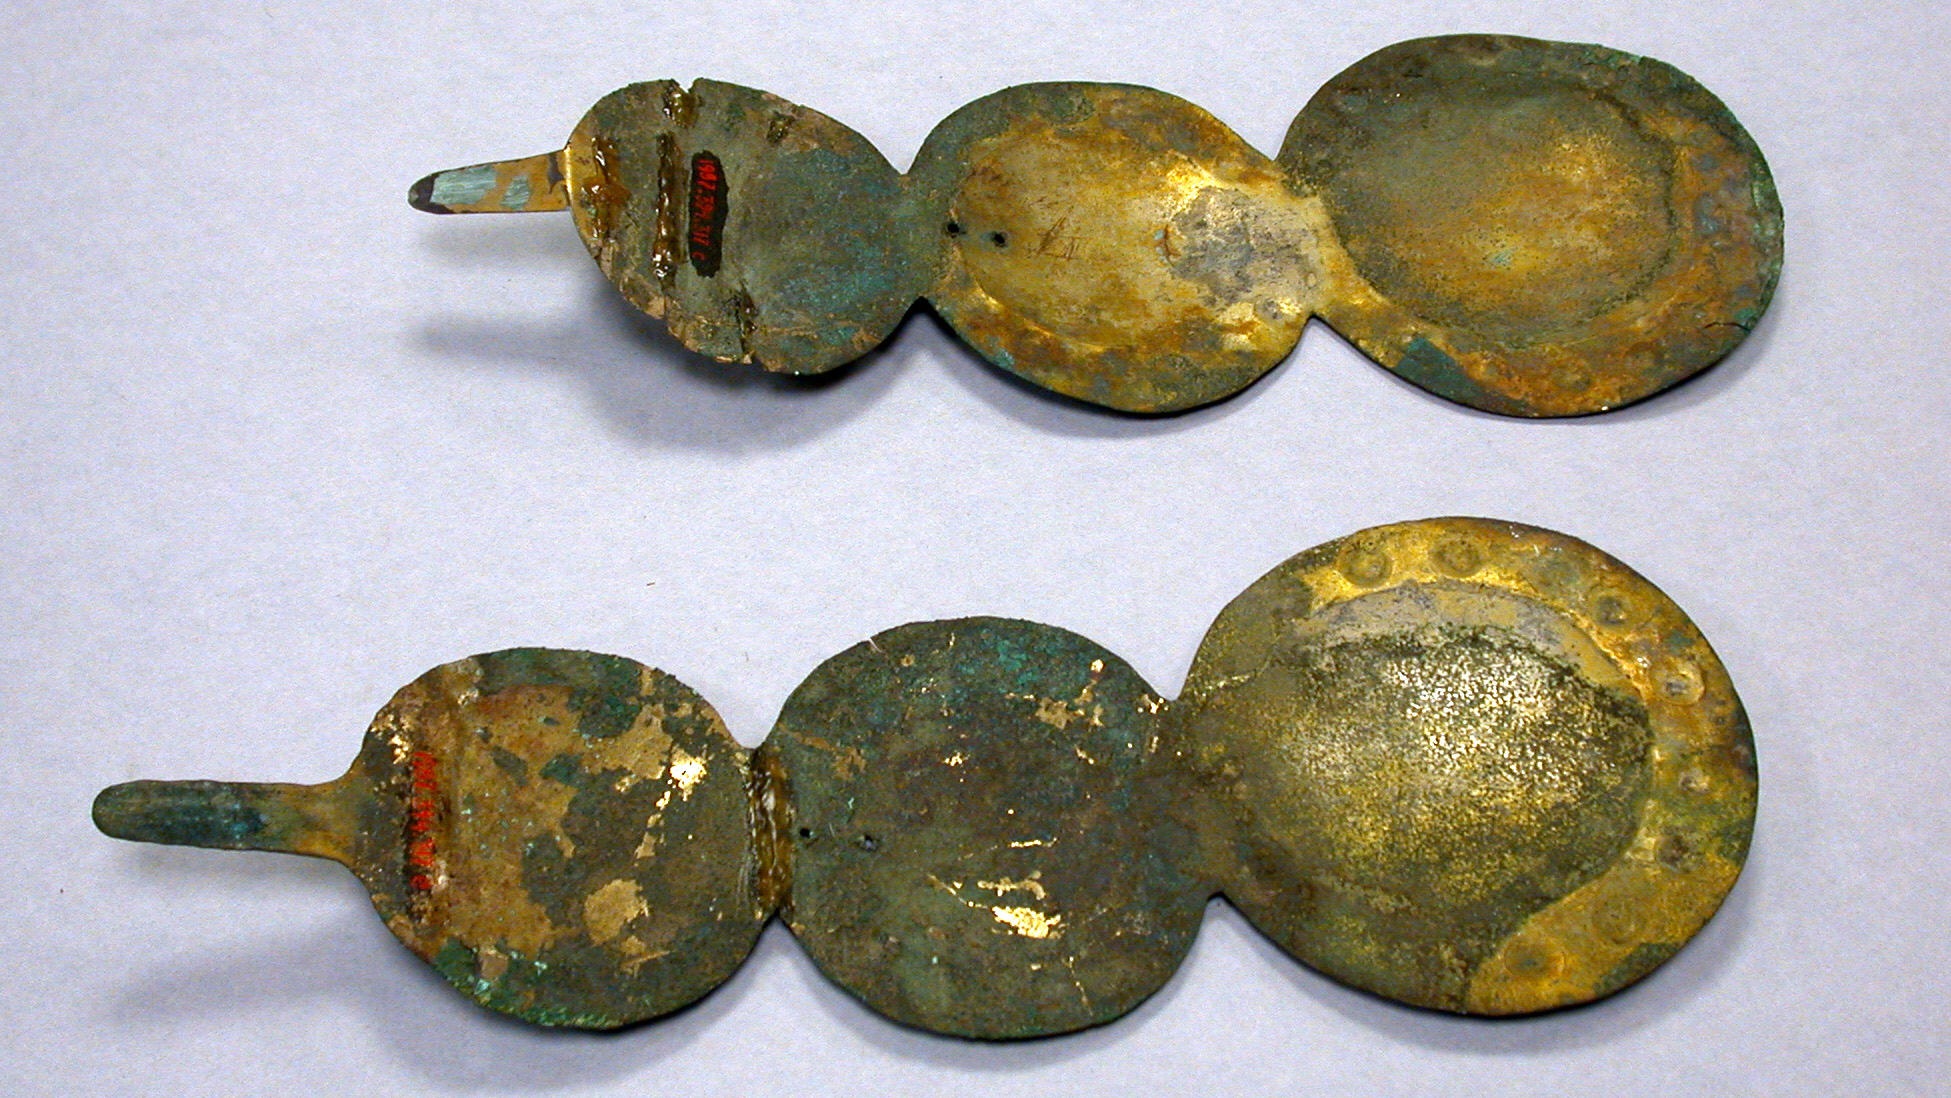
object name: crown plume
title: Plumes from Silvered Crown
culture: chimú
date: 1101-1500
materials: silver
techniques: hammering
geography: peru